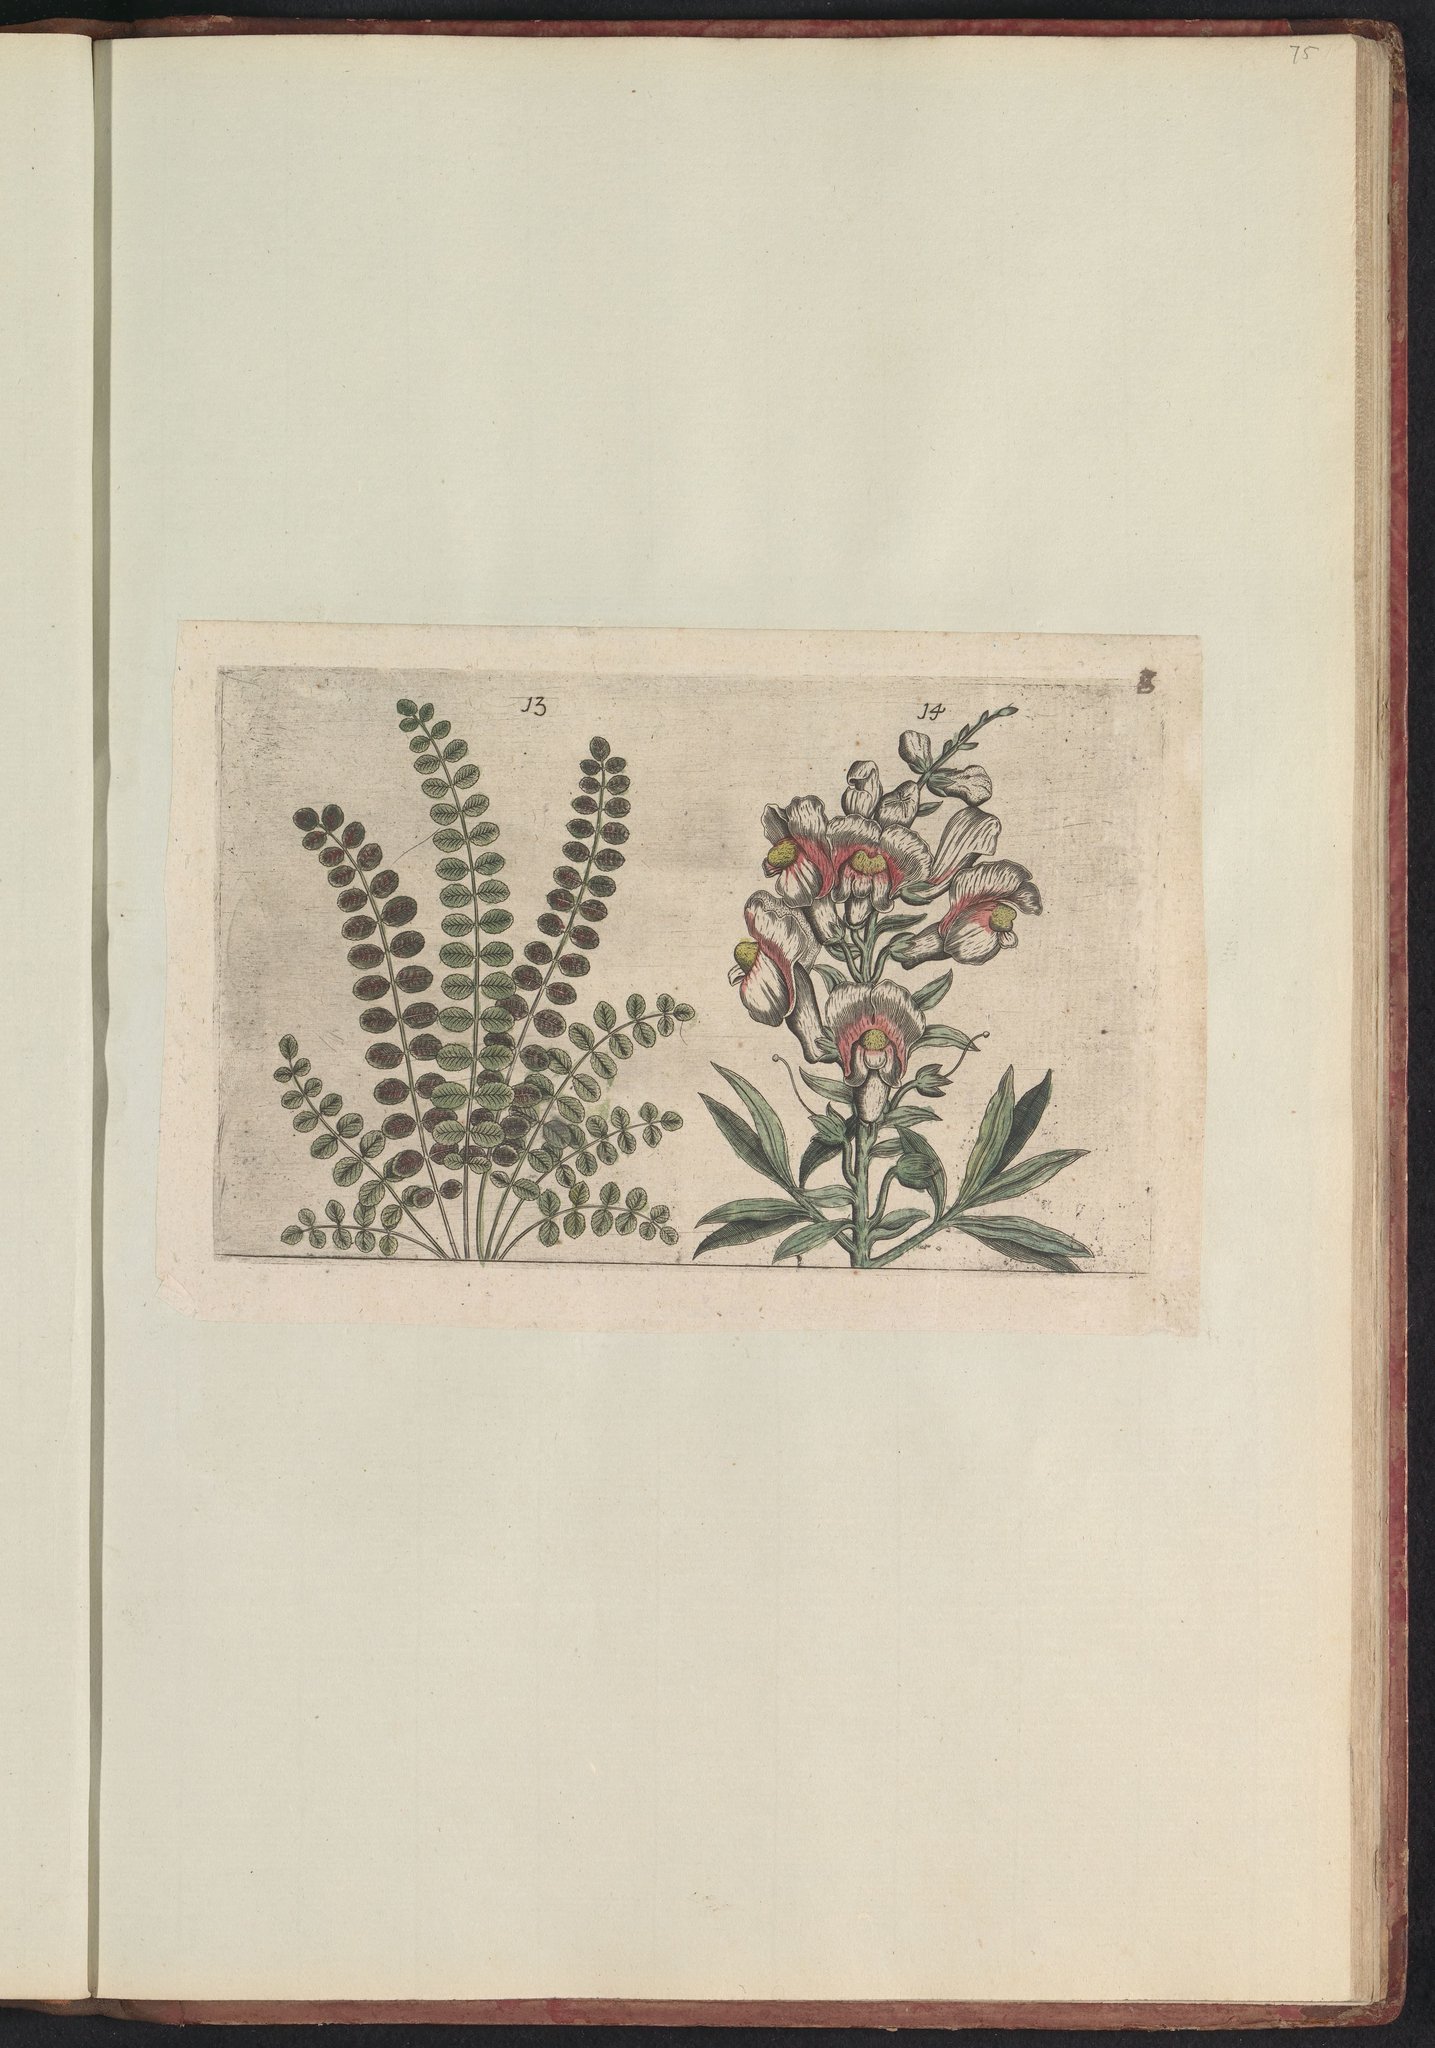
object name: print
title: Kleine pimpernel (Sanguisorba minor) en grote leeuwenbek (Antirrhinum majus)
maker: Anonymous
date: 1604-1632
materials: ink, paper, watercolor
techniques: engraving, hand coloring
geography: cologne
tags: flowers: snapdragon, plants and herbs: burnet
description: Kleine pimpernel en grote leeuwenbek. Figs. 13 en 14 op een blad met de hand genummerd 8. In: Anselmi Boëtii de Boot I.C. Brugensis & Rodolphi II. Imp. Roman. medici a cubiculis Florum, Herbarum, ac fructuum selectiorum icones, & vires pleraeque hactenus ignotæ. Onderdeel van het album met bladen en platen uit De Boodts herbarium van 1640. Het twaalfde van twaalf albums met aquarellen van dieren, vogels en planten bekend rond 1600, gemaakt in opdracht van keizer Rudolf II.